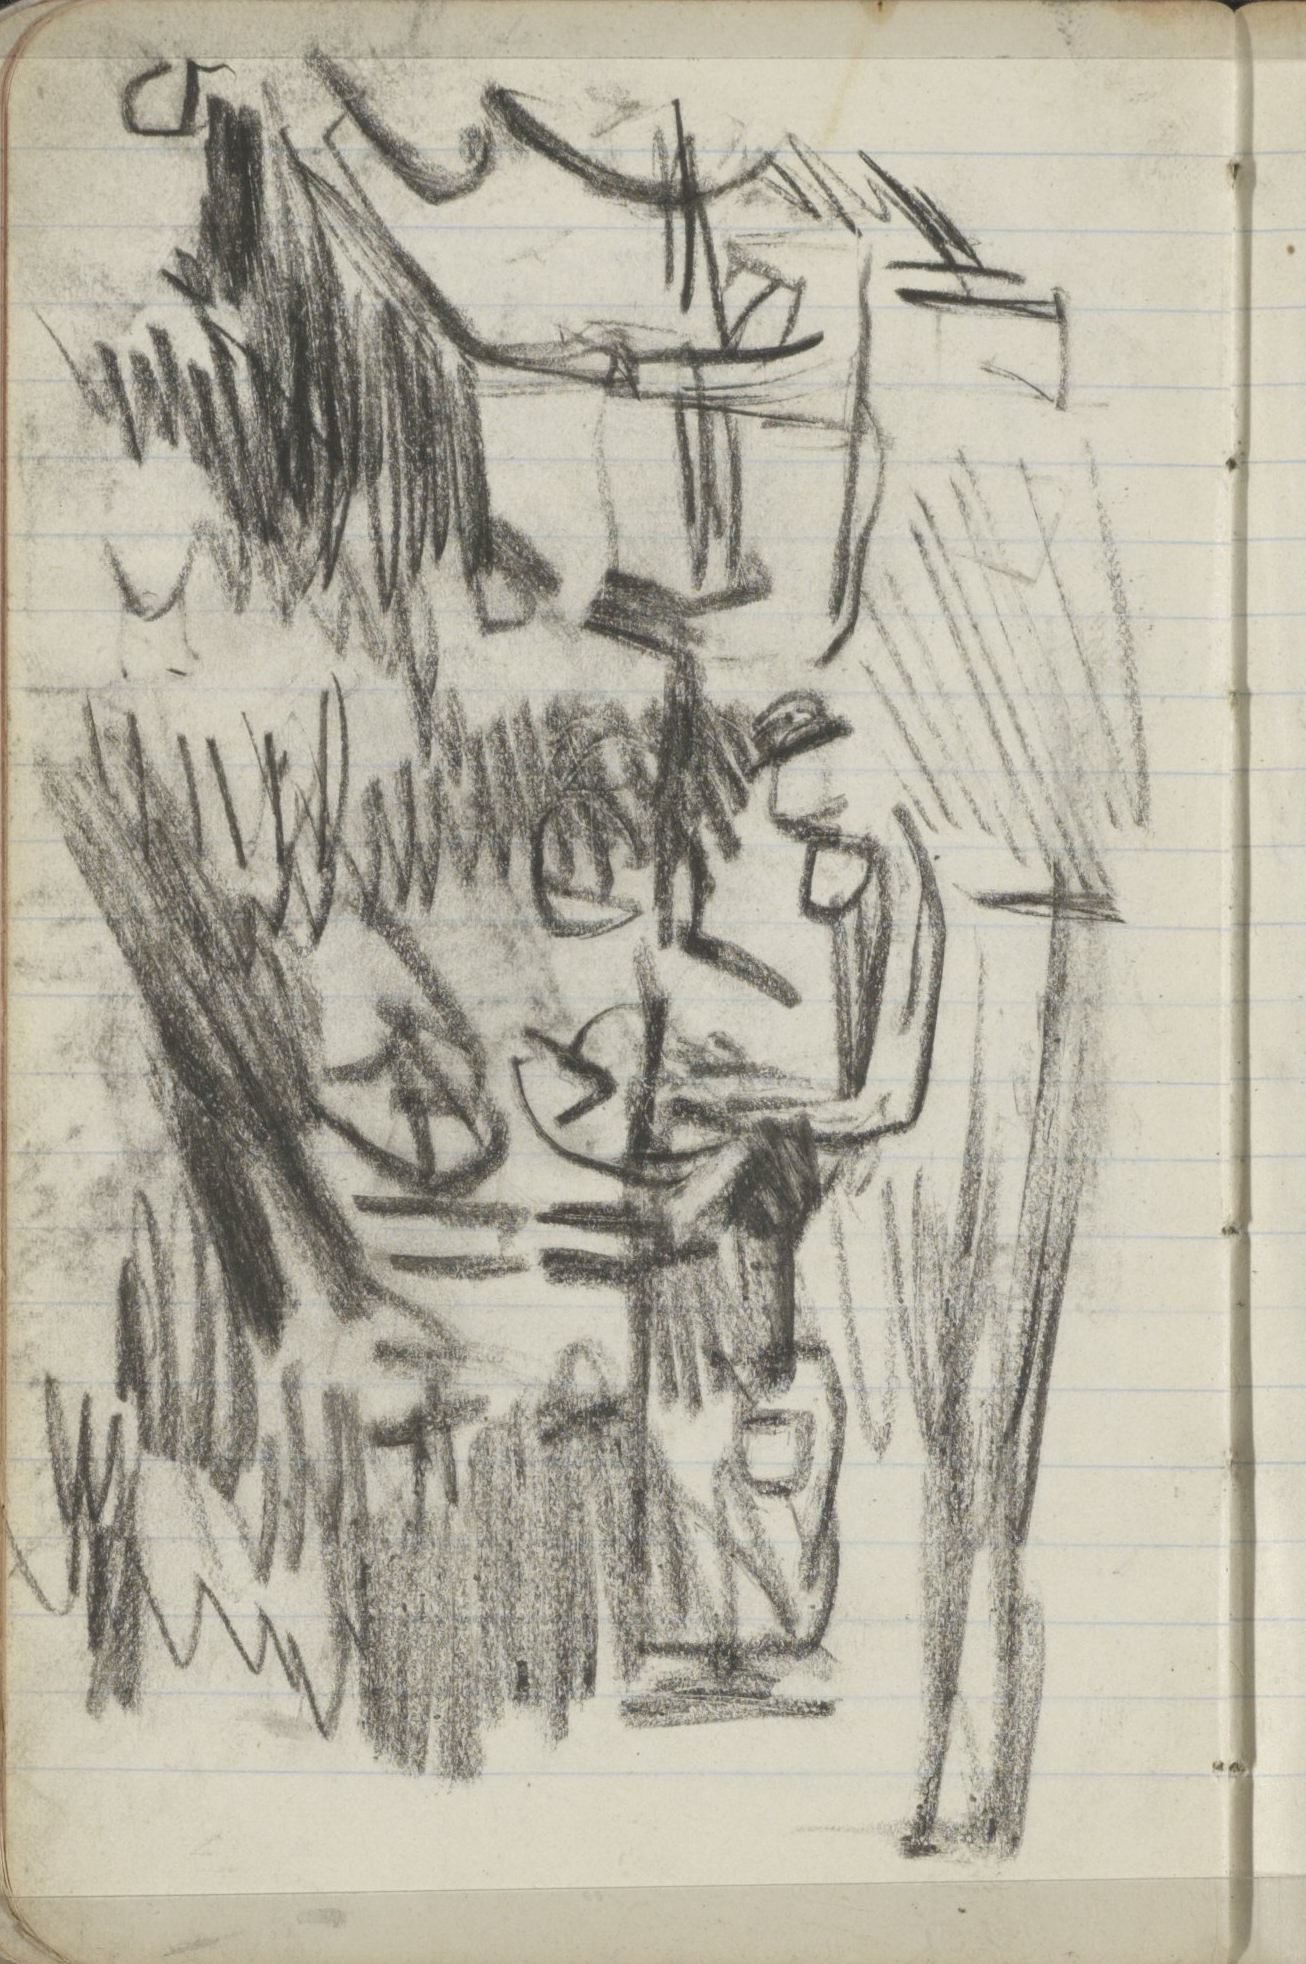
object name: sketchbook leaf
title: Rijtuigen met paarden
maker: george hendrik breitner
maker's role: draughtsman, painter, print maker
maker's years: 1857-1923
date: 1893-1894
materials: chalk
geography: amsterdam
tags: four-wheeled, animal-drawn vehicle, e.g.: cab, carriage, coach, horse, amsterdam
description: Pagina 66 uit een schetsboek met 36 bladen.